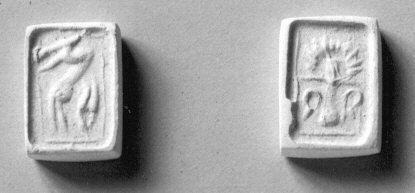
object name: stamp seal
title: Rectangular plaque seal, engraved on two faces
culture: cypriot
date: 1200-1001 BCE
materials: stone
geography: cyprus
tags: animals